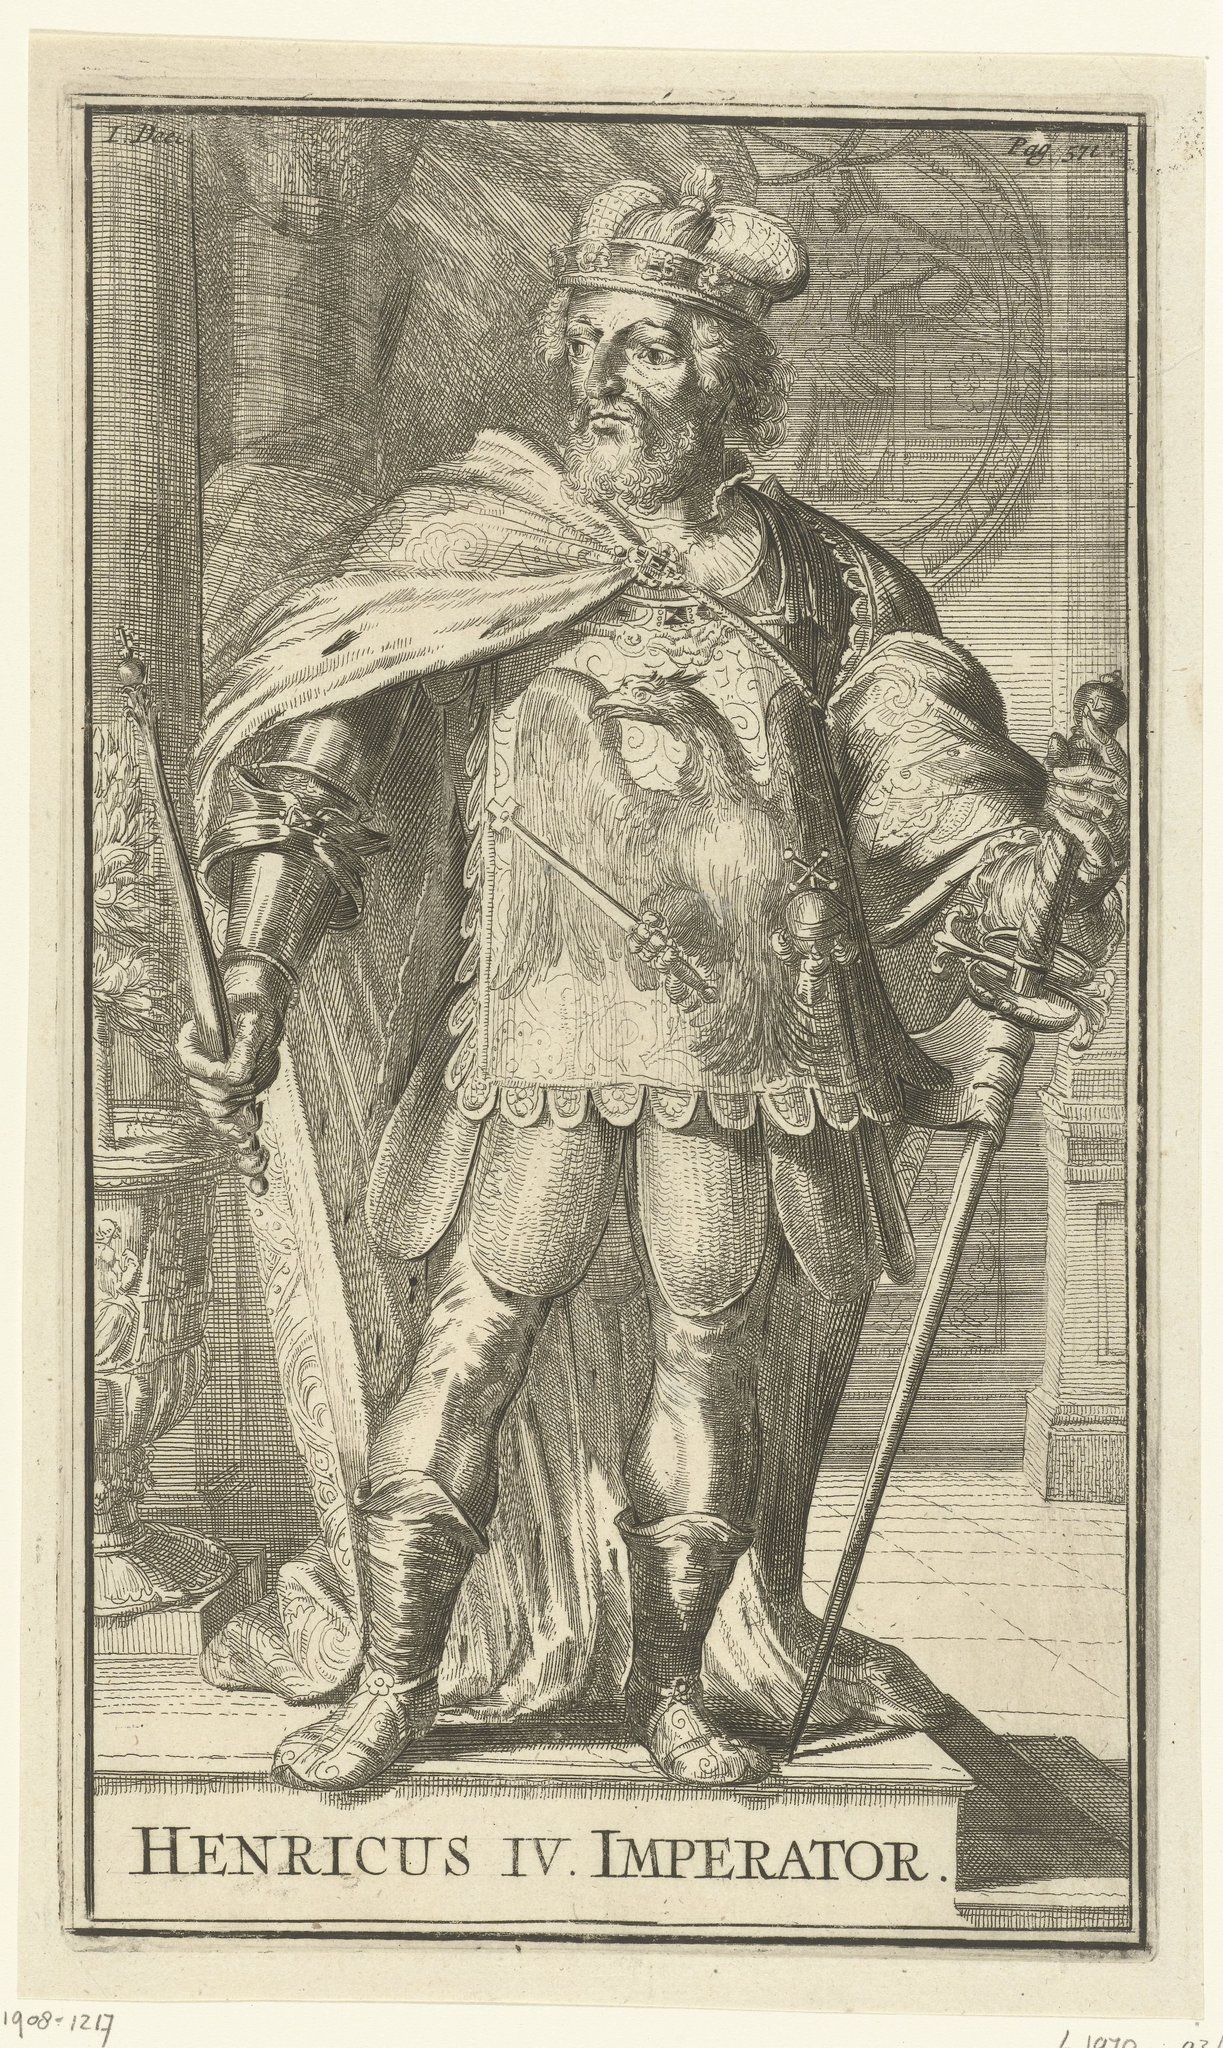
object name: print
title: Henricus IV. Imperator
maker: romeyn de hooghe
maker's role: draughtsman, goldsmith, painter, print maker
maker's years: 1645-1708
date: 1701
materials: paper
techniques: engraving, etching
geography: netherlands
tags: liège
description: Blad uit: Godfried Arnold, Historie der kerken en ketteren van den beginne des Nieuwen Testaments tot aan het jaar onses Heeren 1688, Amsterdam (Sebastiaan Petzold) 1701, deel 1, p. 571.